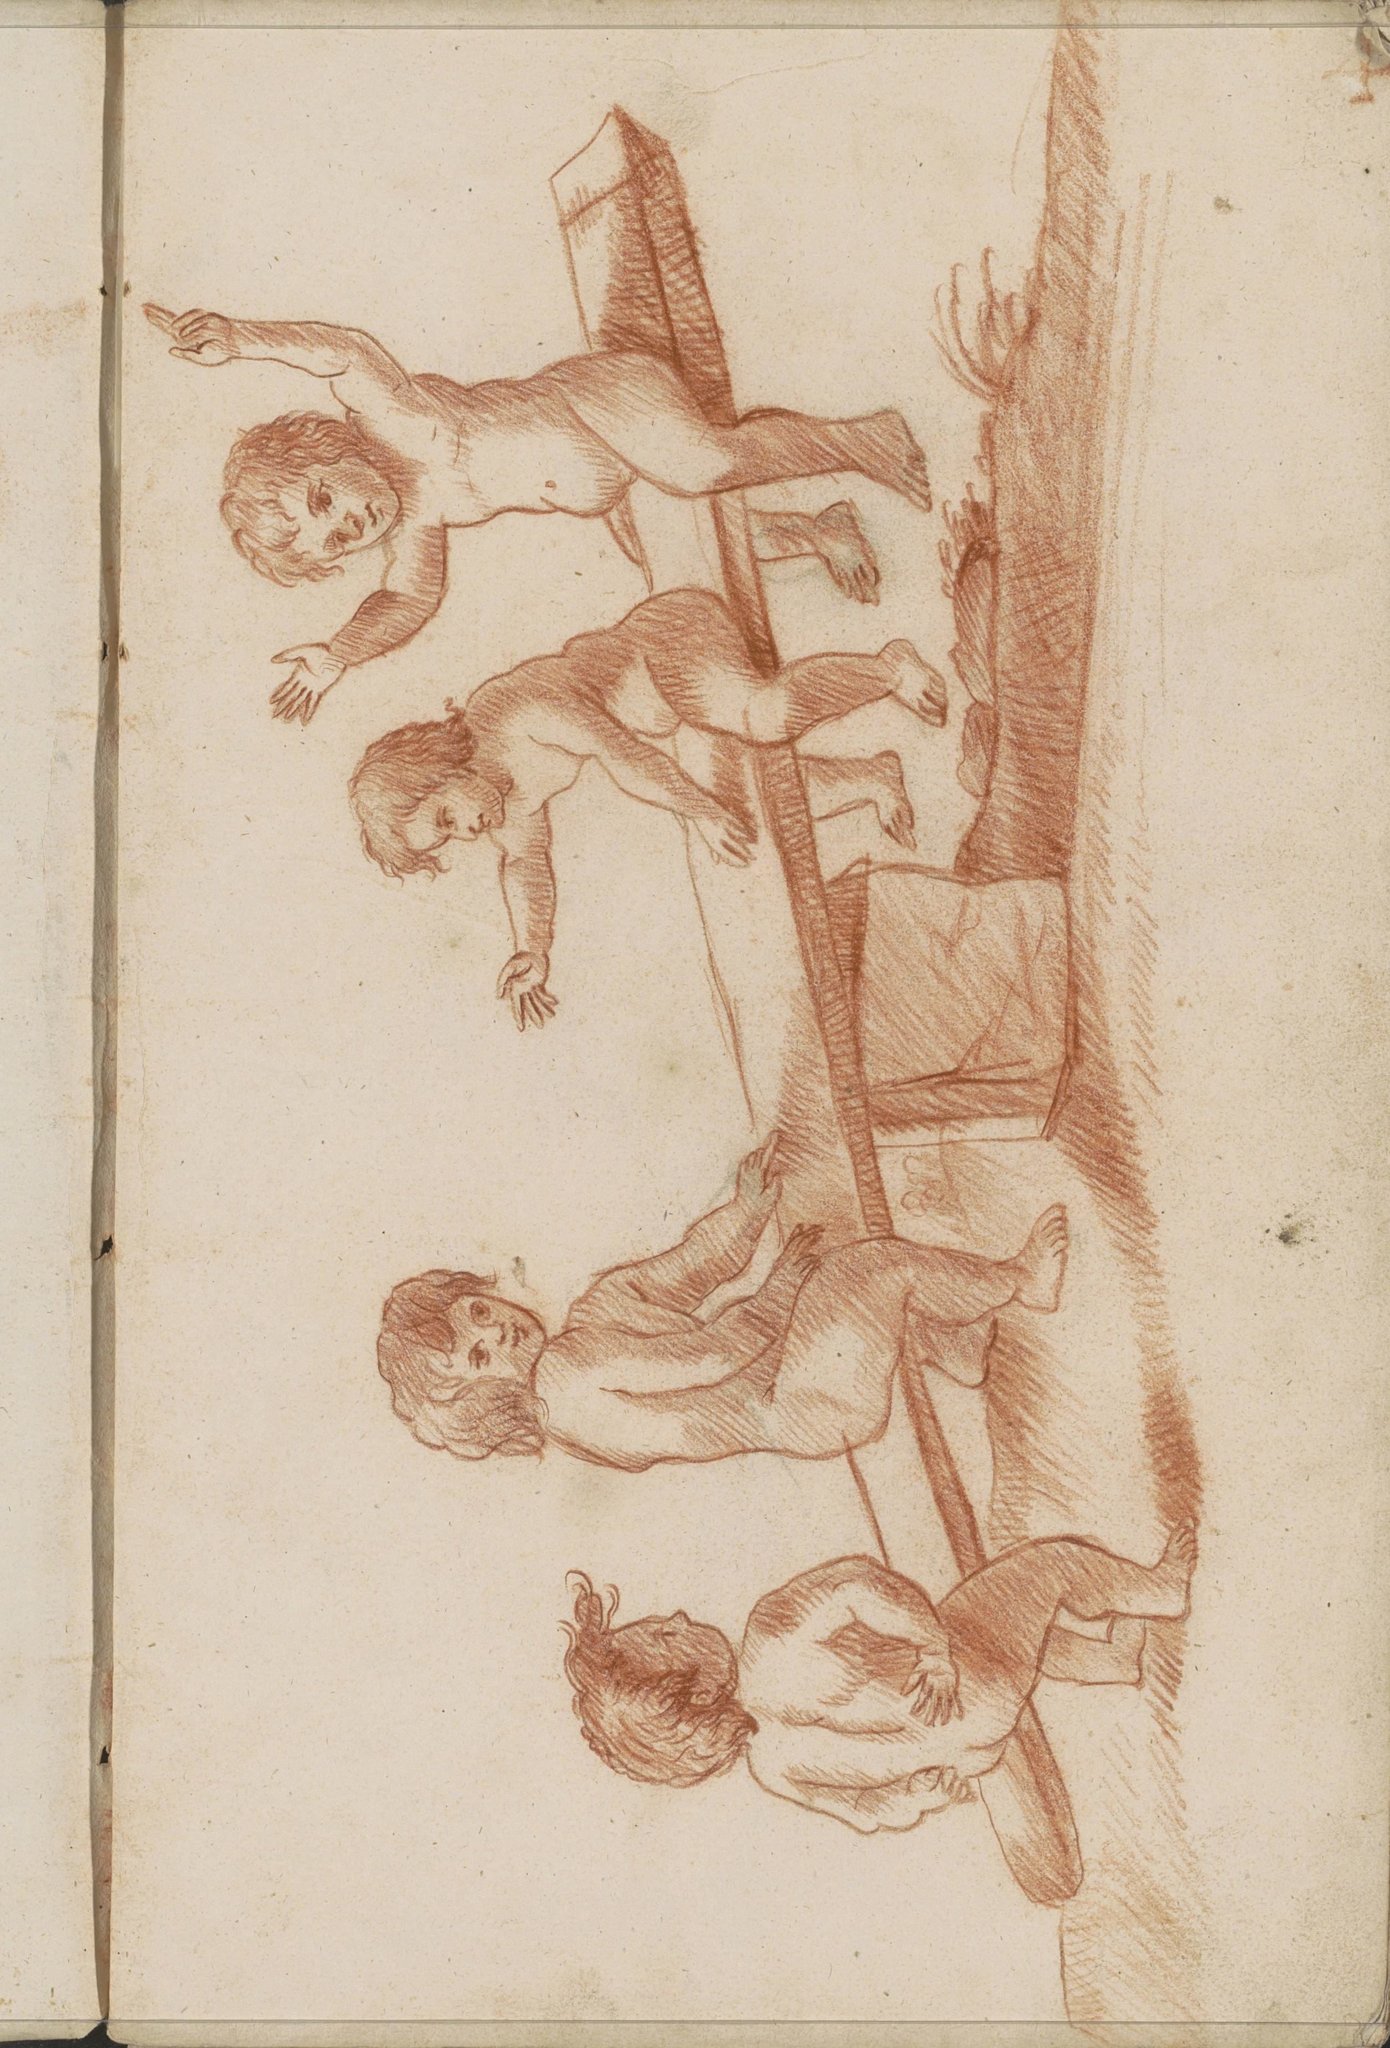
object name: sketchbook leaf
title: Vier putti op een wip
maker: hendrick van beaumont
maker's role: draughtsman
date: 1696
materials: chalk, paper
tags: bascule bridge, cupids: 'amores', 'amoretti', 'putti'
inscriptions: number: ‘4’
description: Blad 2 recto uit een schetsboek met 30 bladen.